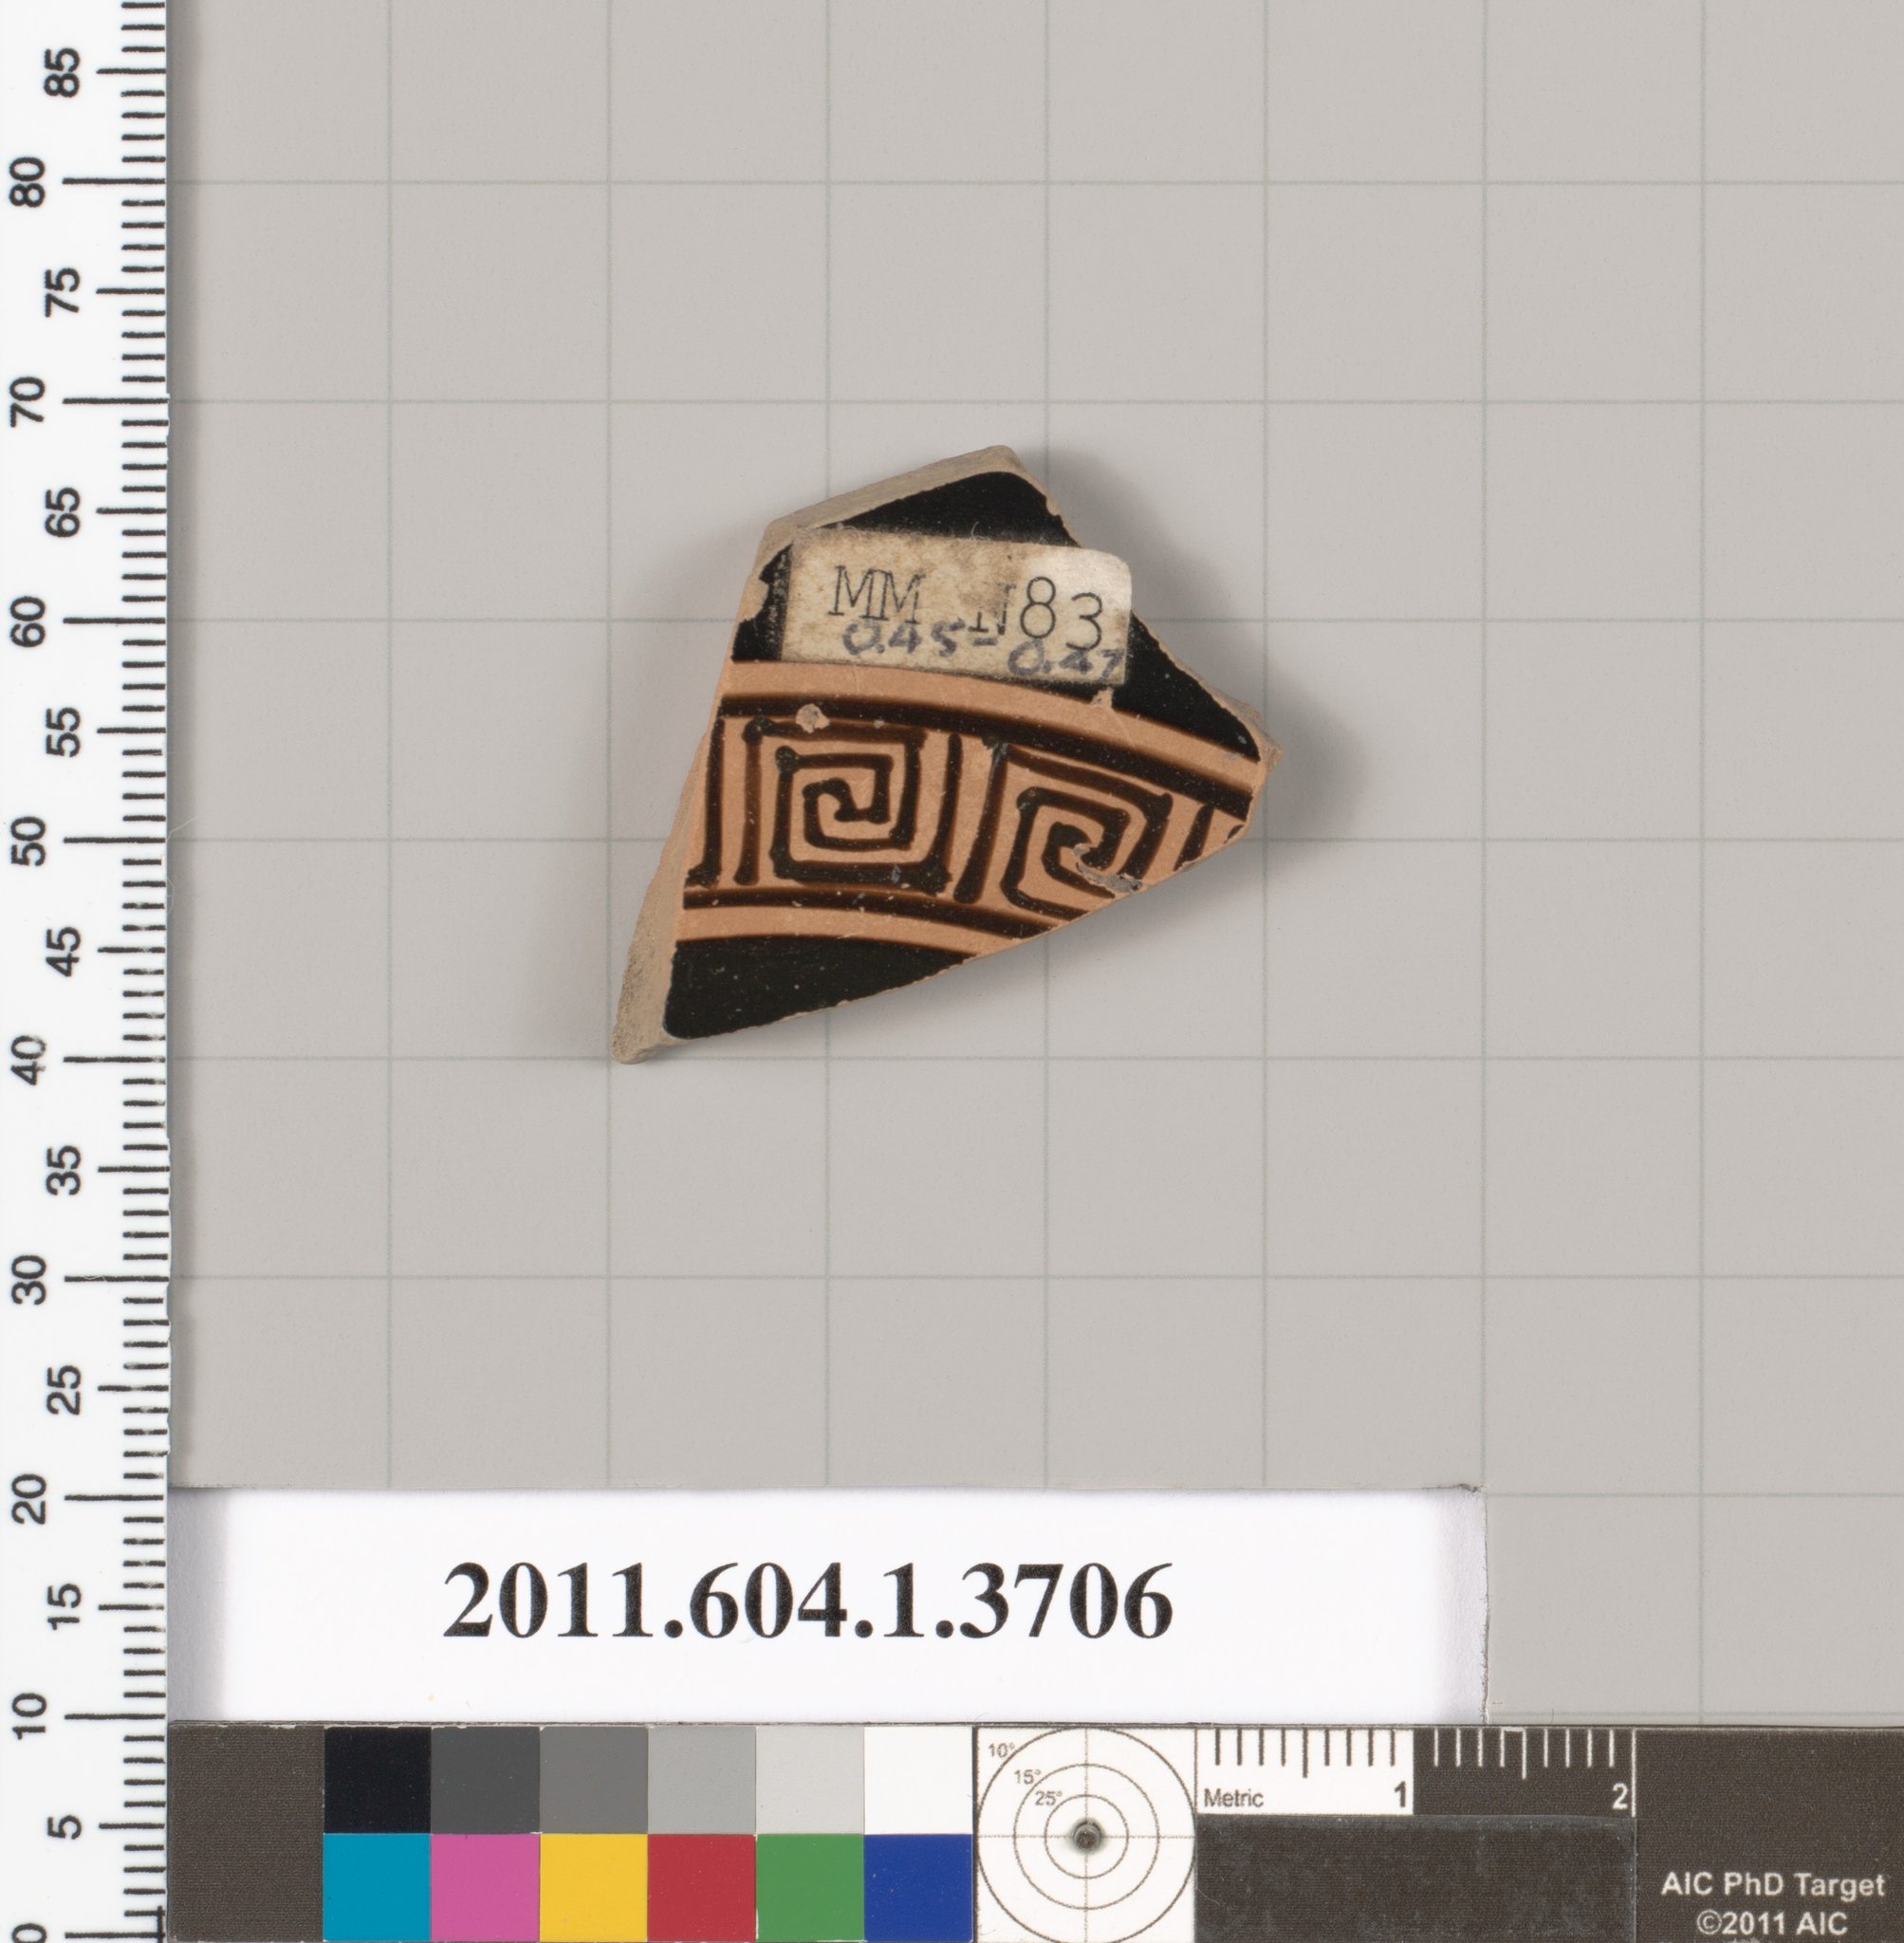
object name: kylix fragment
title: Terracotta fragment of a kylix (drinking cup)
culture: greek, attic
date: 500-470 BCE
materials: terracotta